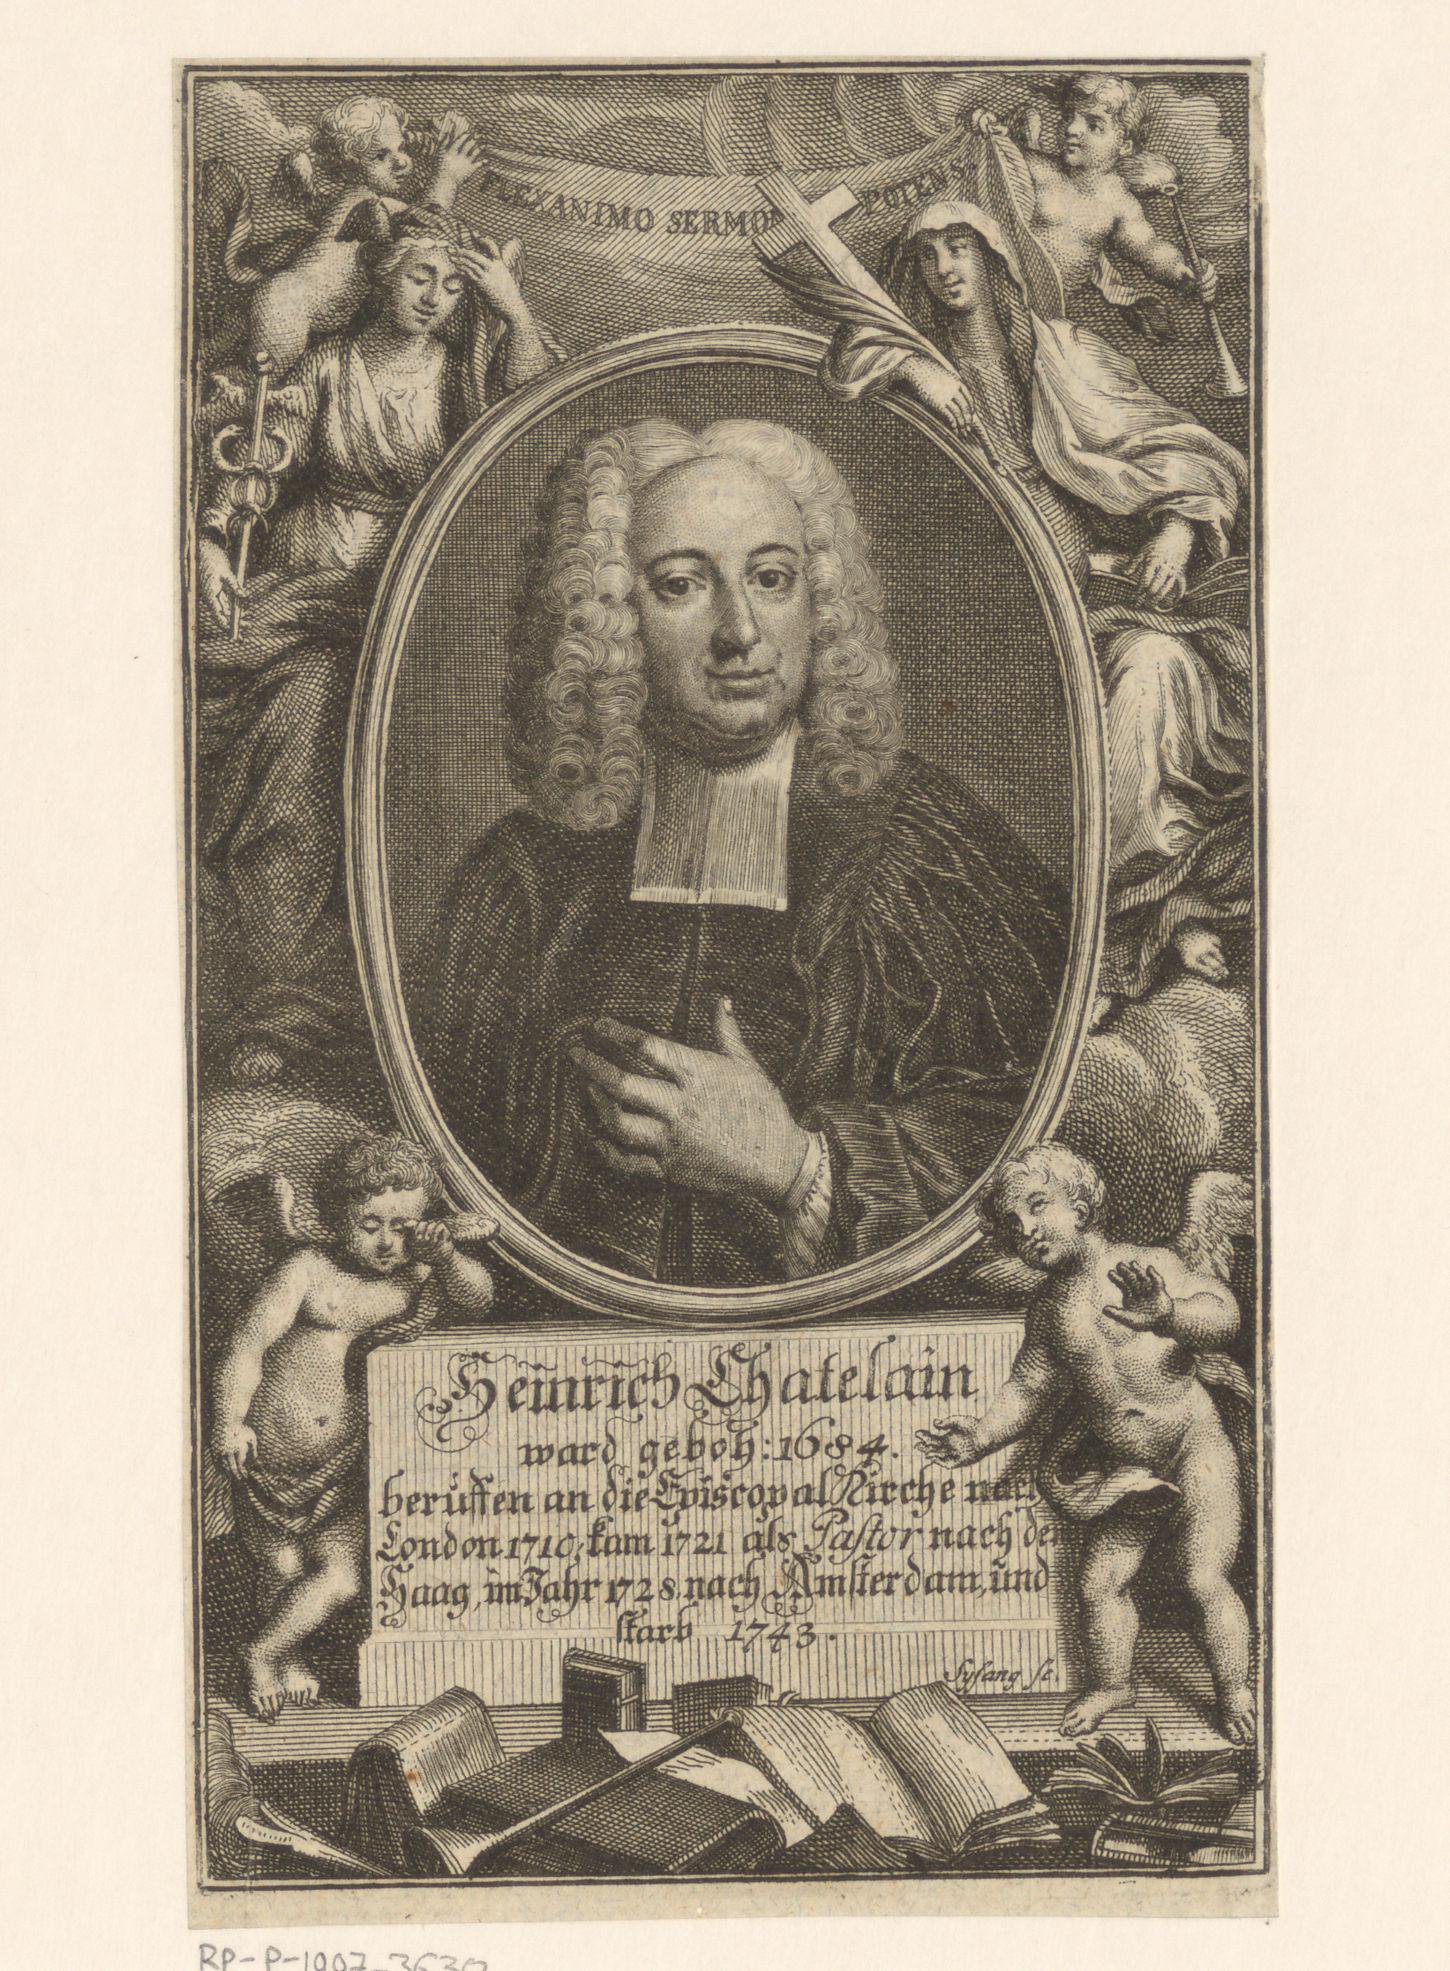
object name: print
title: Portret van Henri Chatelain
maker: johann christoph sysang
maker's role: print maker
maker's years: 1703-1757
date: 1743-1757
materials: paper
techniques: engraving, etching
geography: leipzig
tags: paris, amsterdam, fides (faith) as roman personification, historical persons, book, caduceus (staff with two snakes, attribute of mercury), cupids: 'amores', 'amoretti', 'putti'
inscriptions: collector's mark: Lugt 2228